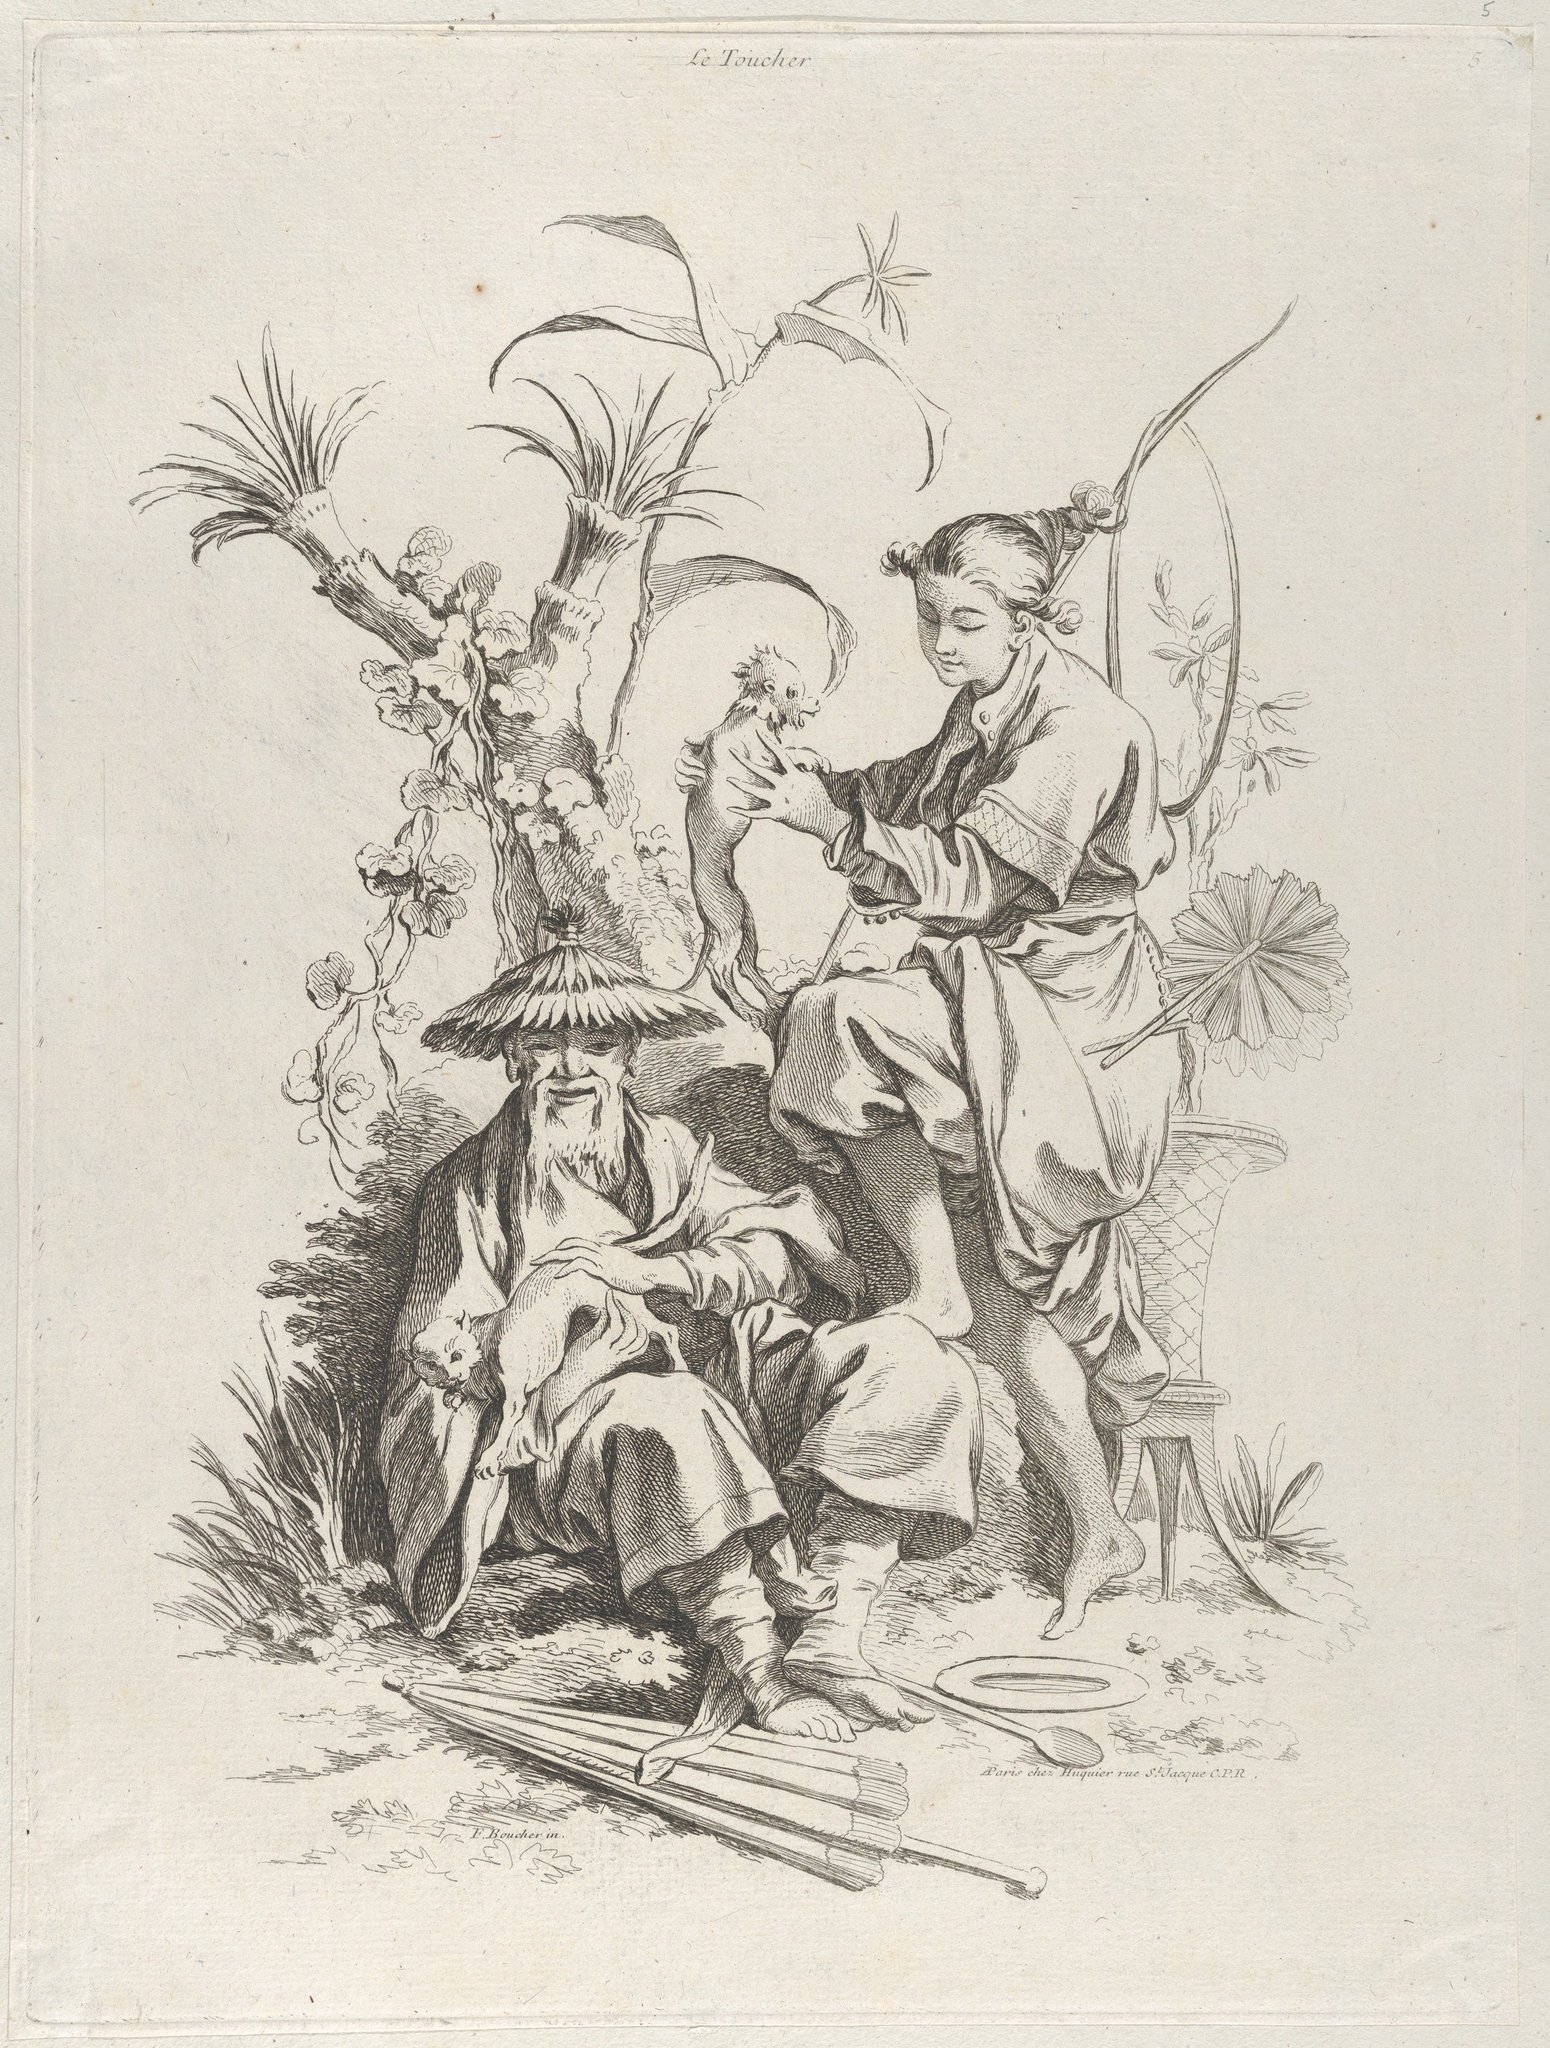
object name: print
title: Touch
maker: françois boucher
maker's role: artist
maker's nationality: french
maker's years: 1703-1770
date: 1720-1770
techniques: engraving, etching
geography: france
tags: animals,chinoiserie,men,women